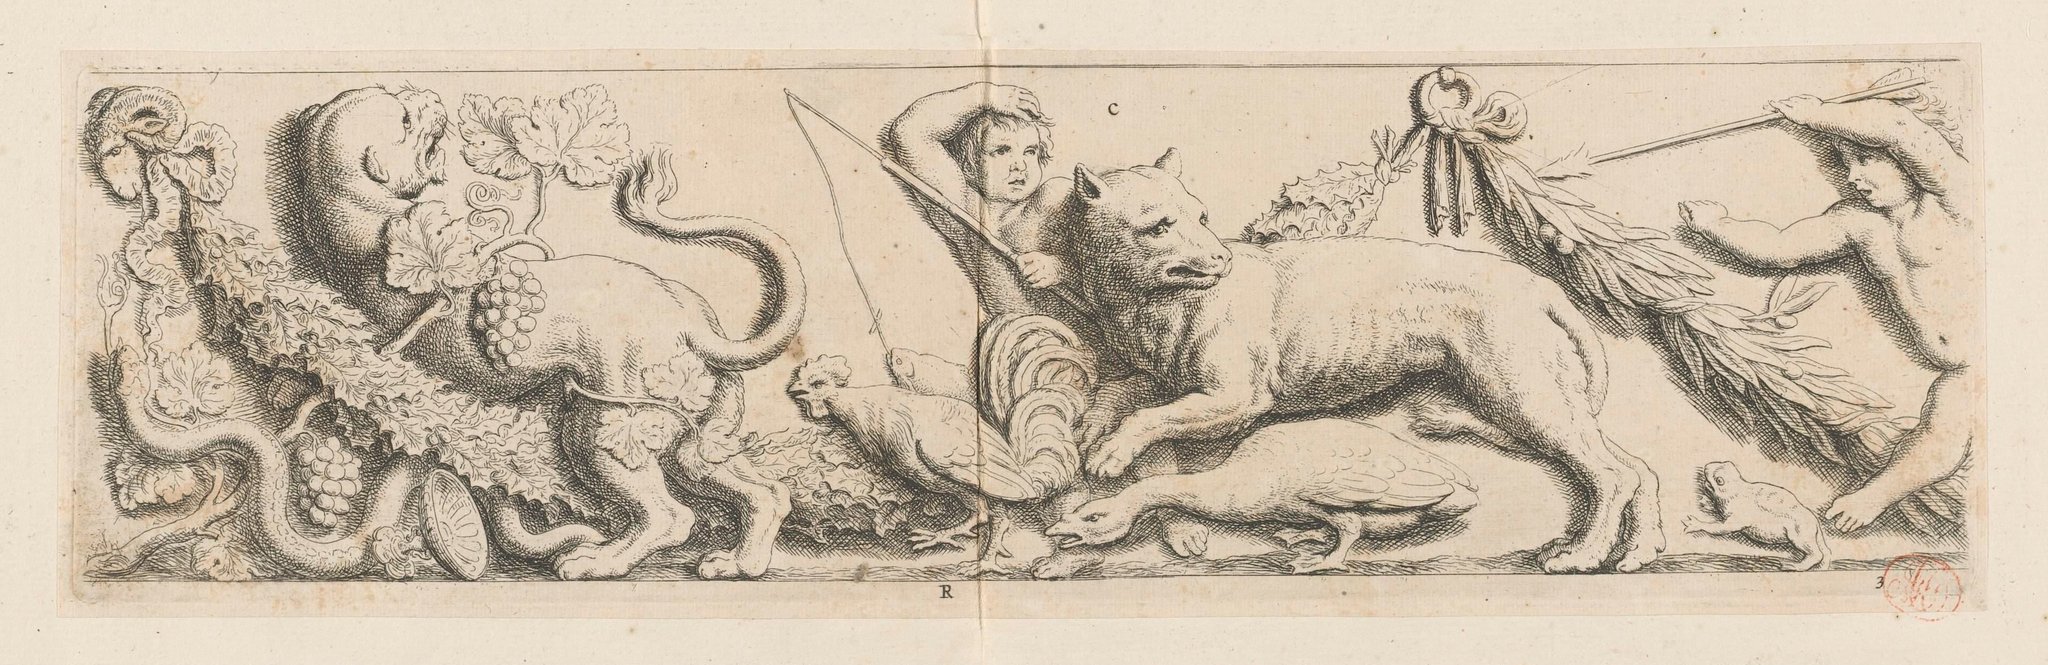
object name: book illustration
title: Deel van fries op schouw in Vroedschapskamer van het Stadhuis op de Dam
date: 1663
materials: paper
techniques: engraving, etching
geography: amsterdam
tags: snakes, tailless amphibians: toad, water-birds: goose, strife between virtues and vices, psychomachy, fowl (cock, hen, chicken, etc.), beasts of prey, predatory animals, allegory, personification of good government, cupids: 'amores', 'amoretti', 'putti', beasts of prey, predatory animals: wolf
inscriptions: collector's mark: Lugt 195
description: Prent gebruikt in: Secunca pars Praecipuarum effigierum ac ornamentorum amplissime Curiae Amstelrodamensis maiori ex parte in cadido marmore effectorum per Artum Quellinium eiusdem Civitatis Statuarium / Het tweede deel Van de voornaemste Statuen ende Cieraten van 't konst-rijcke Stadt-huys van Amstelredam 'tmeeste in Marmer gemaeckt door Artus Quellinus Beelthouwer der voorseyde Stadt. Amsterdam: Artus Quellinus (I), 1663. Zie RP-P-AO-22-2-1 voor bijhorende titelpagina. Zie RP-P-AO-22-2-2 voor bijhorend register. Zie RP-P-AO-22-2A, RP-P-AO-22-2B, RP-P-AO-22-2C-1, RP-P-AO-22-2C-2, RP-P-AO-22-2C-3, RP-P-AO-22-2C-4, RP-P-AO-22-2D-1, RP-P-AO-22-2D-2, RP-P-AO-22-2D-3, RP-P-AO-22-2E-1, RP-P-AO-22-2E-2, RP-P-AO-22-2E-3, RP-P-AO-22-2E-4, RP-P-AO-22-2F-1, RP-P-AO-22-2F-2, RP-P-AO-22-2F-3, RP-P-AO-22-2G, RP-P-AO-22-2H, RP-P-AO-22-2I, RP-P-AO-22-2K, RP-P-AO-22-2L, RP-P-AO-22-2M, RP-P-AO-22-2N, RP-P-AO-22-2O-1, RP-P-AO-22-2O-2, RP-P-AO-22-2O-3, RP-P-AO-22-2O-4, RP-P-AO-22-2O-5, RP-P-AO-22-2O-6, RP-P-AO-22-2O-7, RP-P-AO-22-2P-1, RP-P-AO-22-2P-2, RP-P-AO-22-2Q-1, RP-P-AO-22-2Q-2, RP-P-AO-22-2Q-3, RP-P-AO-22-2R-1, RP-P-AO-22-2R-2, RP-P-AO-22-2S, RP-P-AO-22-2T-1, RP-P-AO-22-2T-2, RP-P-AO-22-2T-3, RP-P-AO-22-2T-4, RP-P-AO-22-2V-1, RP-P-AO-22-2V-2, RP-P-AO-22-2W-1, RP-P-AO-22-2W-2, RP-P-AO-22-2X-1, RP-P-AO-22-2X-2 en RP-P-AO-22-2X-3 voor andere prenten uit deze publicatie. Zelfde staat van prent ook gebruikt in: Secunca pars Praecipuarum effigierum ac ornamentorum amplissime Curiae Amstelrodamensis maiori ex parte in cadido marmore effectorum per Artum Quellinium eiusdem Civitatis Statuarium / Het tweede deel Van de voornaemste Statuen ende Cieraten van 't konst-rijcke Stadt-huys van Amstelredam 'tmeeste in Marmer gemaeckt door Artus Quellinus Beelthouwer der voorseyde Stadt. Amsterdam: Frederik de Wit, 1668. Latere staat van prent ook gebruikt in: Architecture peinture et sculpture de la Maison de Ville d'Amsterdam, representee en CIX. figures en taille-douce (…). Amsterdam: David Mortier, 1719. En in: Architecture peinture et sculpture de la Maison de Ville d'Amsterdam, representee en CIX. figures en taille-douce (…). Amsterdam: Gerard Valck, 1719. En in: Bouw schilder en beeldhouwkonst, van het Stadhuis te Amsteldam, vertoont in CIX figuuren (…). Amsterdam: Covens & Mortier & Covens Jr., s.a. (1774-1783).